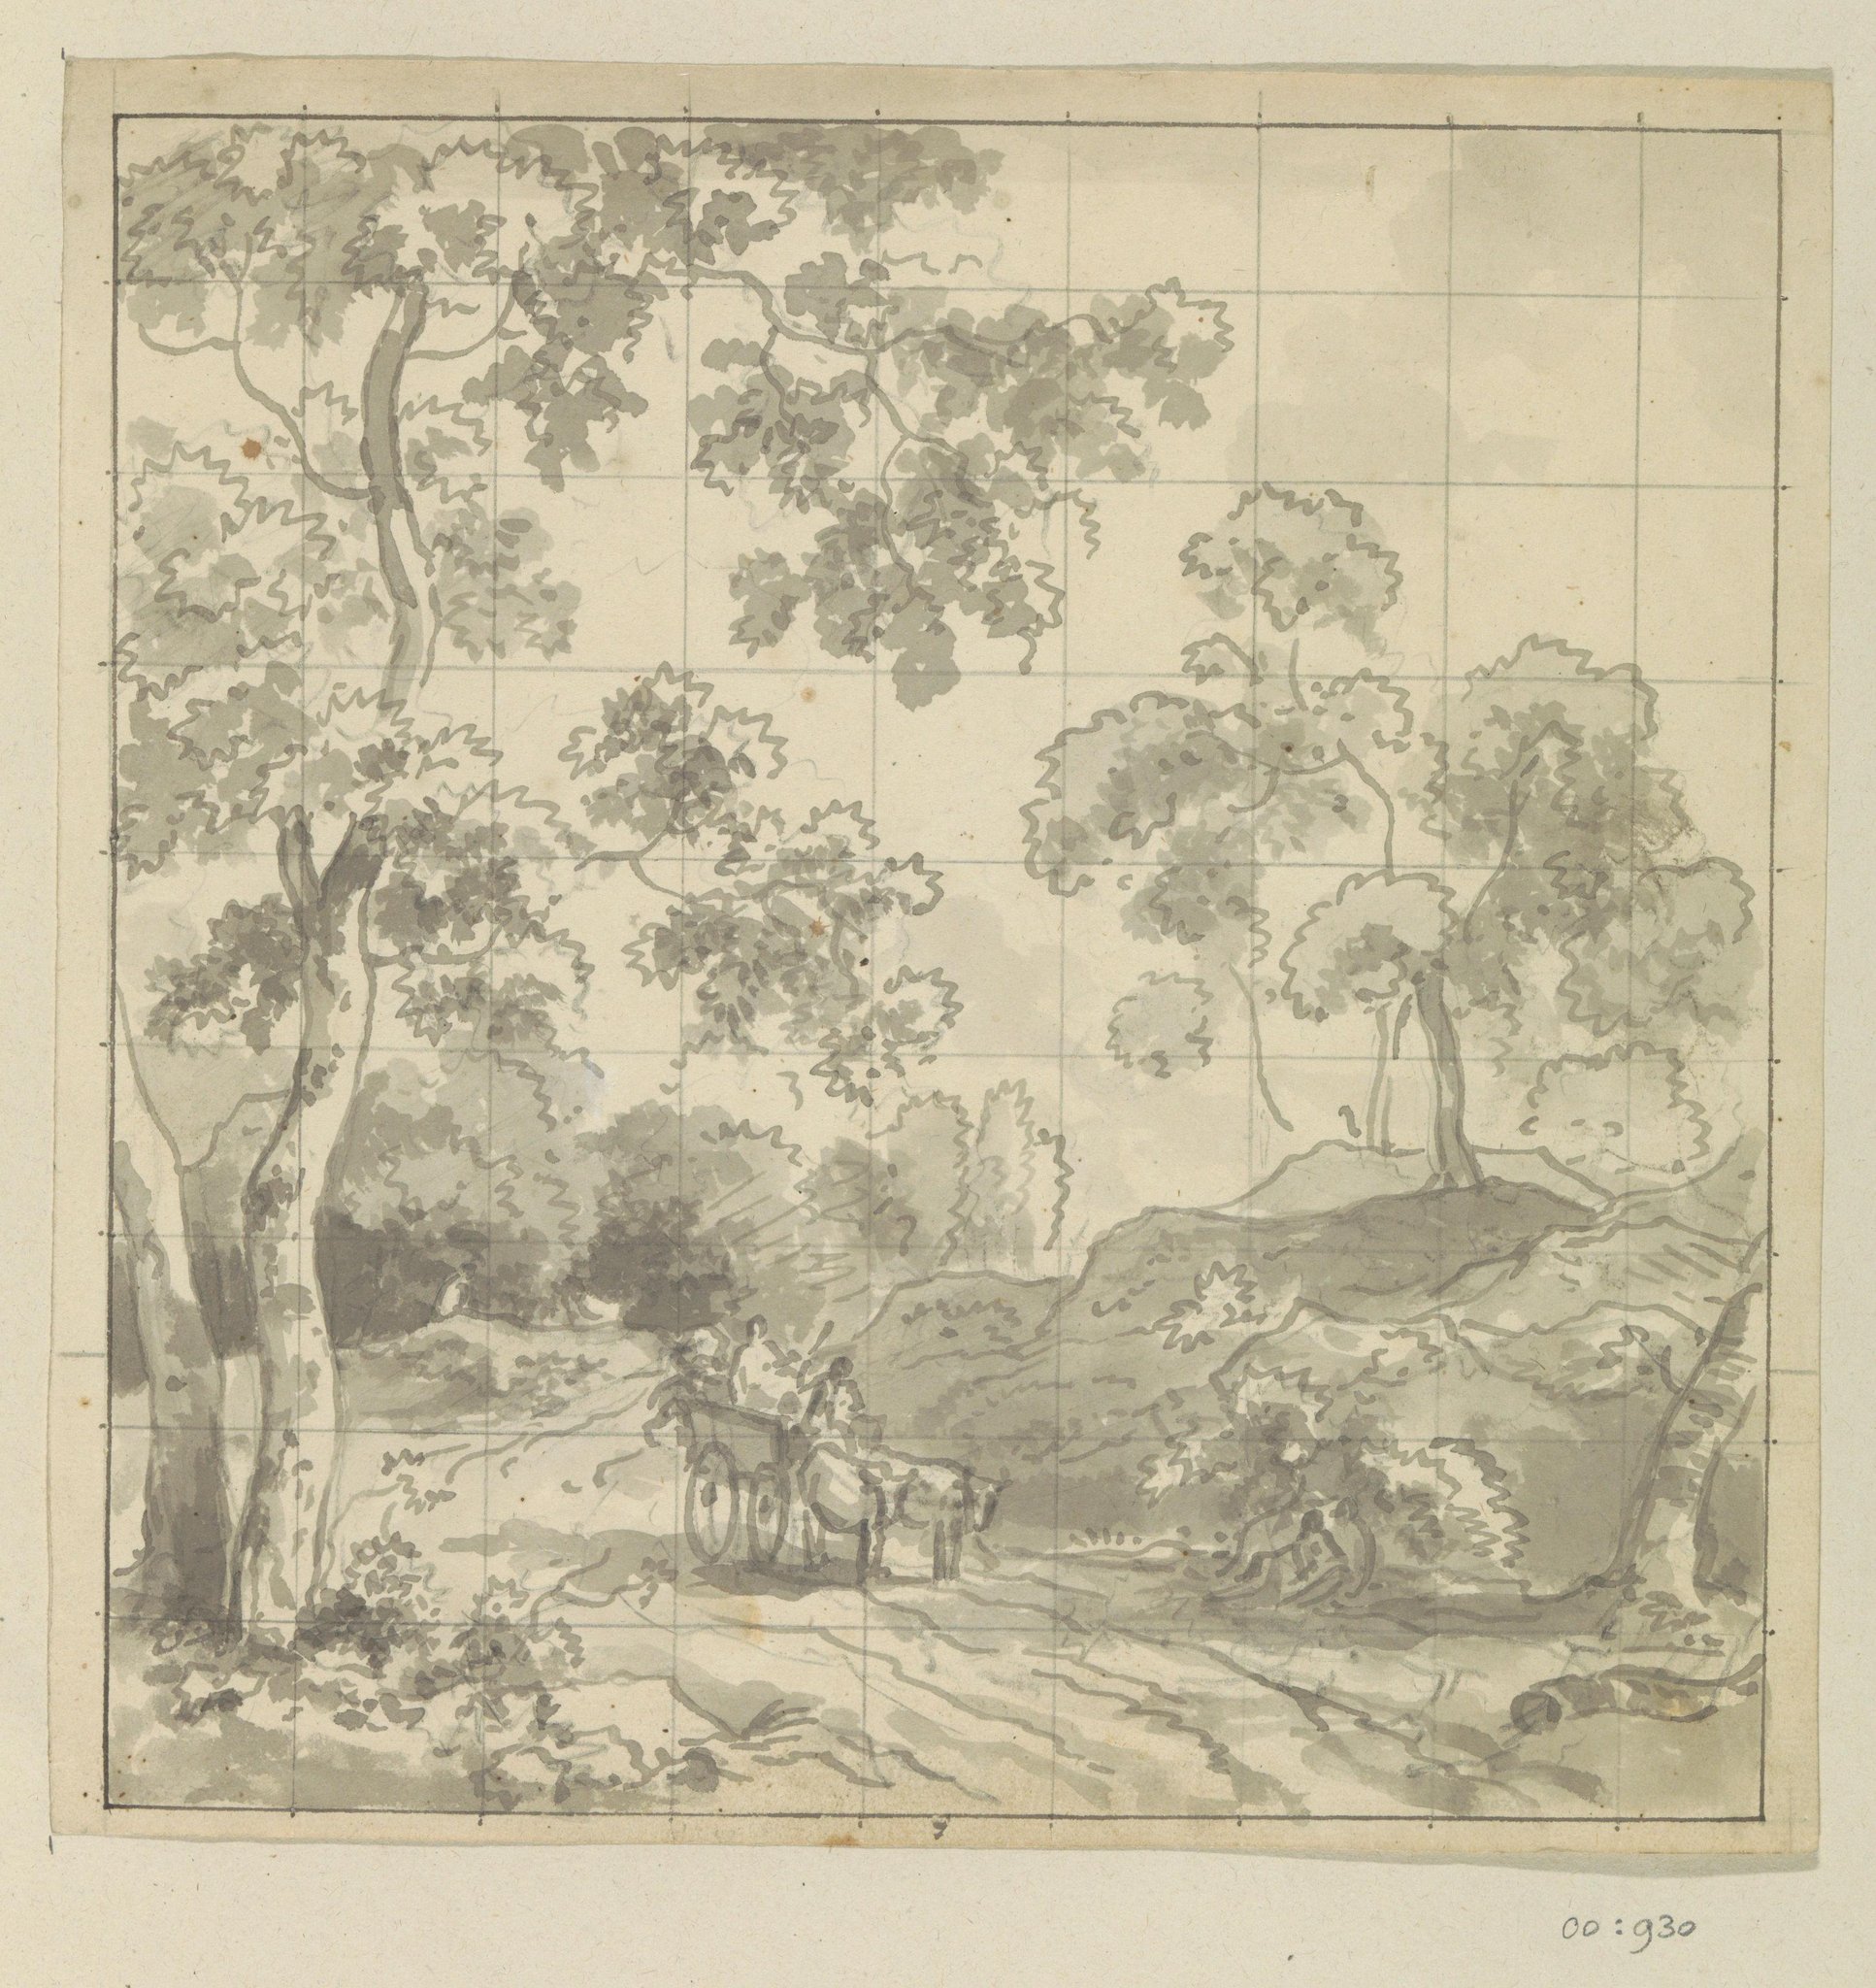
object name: drawing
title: Gezicht op een landweg met paard en wagen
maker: jurriaan andriessen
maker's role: draughtsman, painter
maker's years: 1742-1819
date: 1760-1819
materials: paper, pencil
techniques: brush, pen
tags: animal traction, animal-drawn vehicle (carriage etc.), landscapes in the temperate zone, road, path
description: Mogelijk ontwerp voor een wandschildering. Met op de achtergrond een raster. Tekening maakt deel uit van een album.